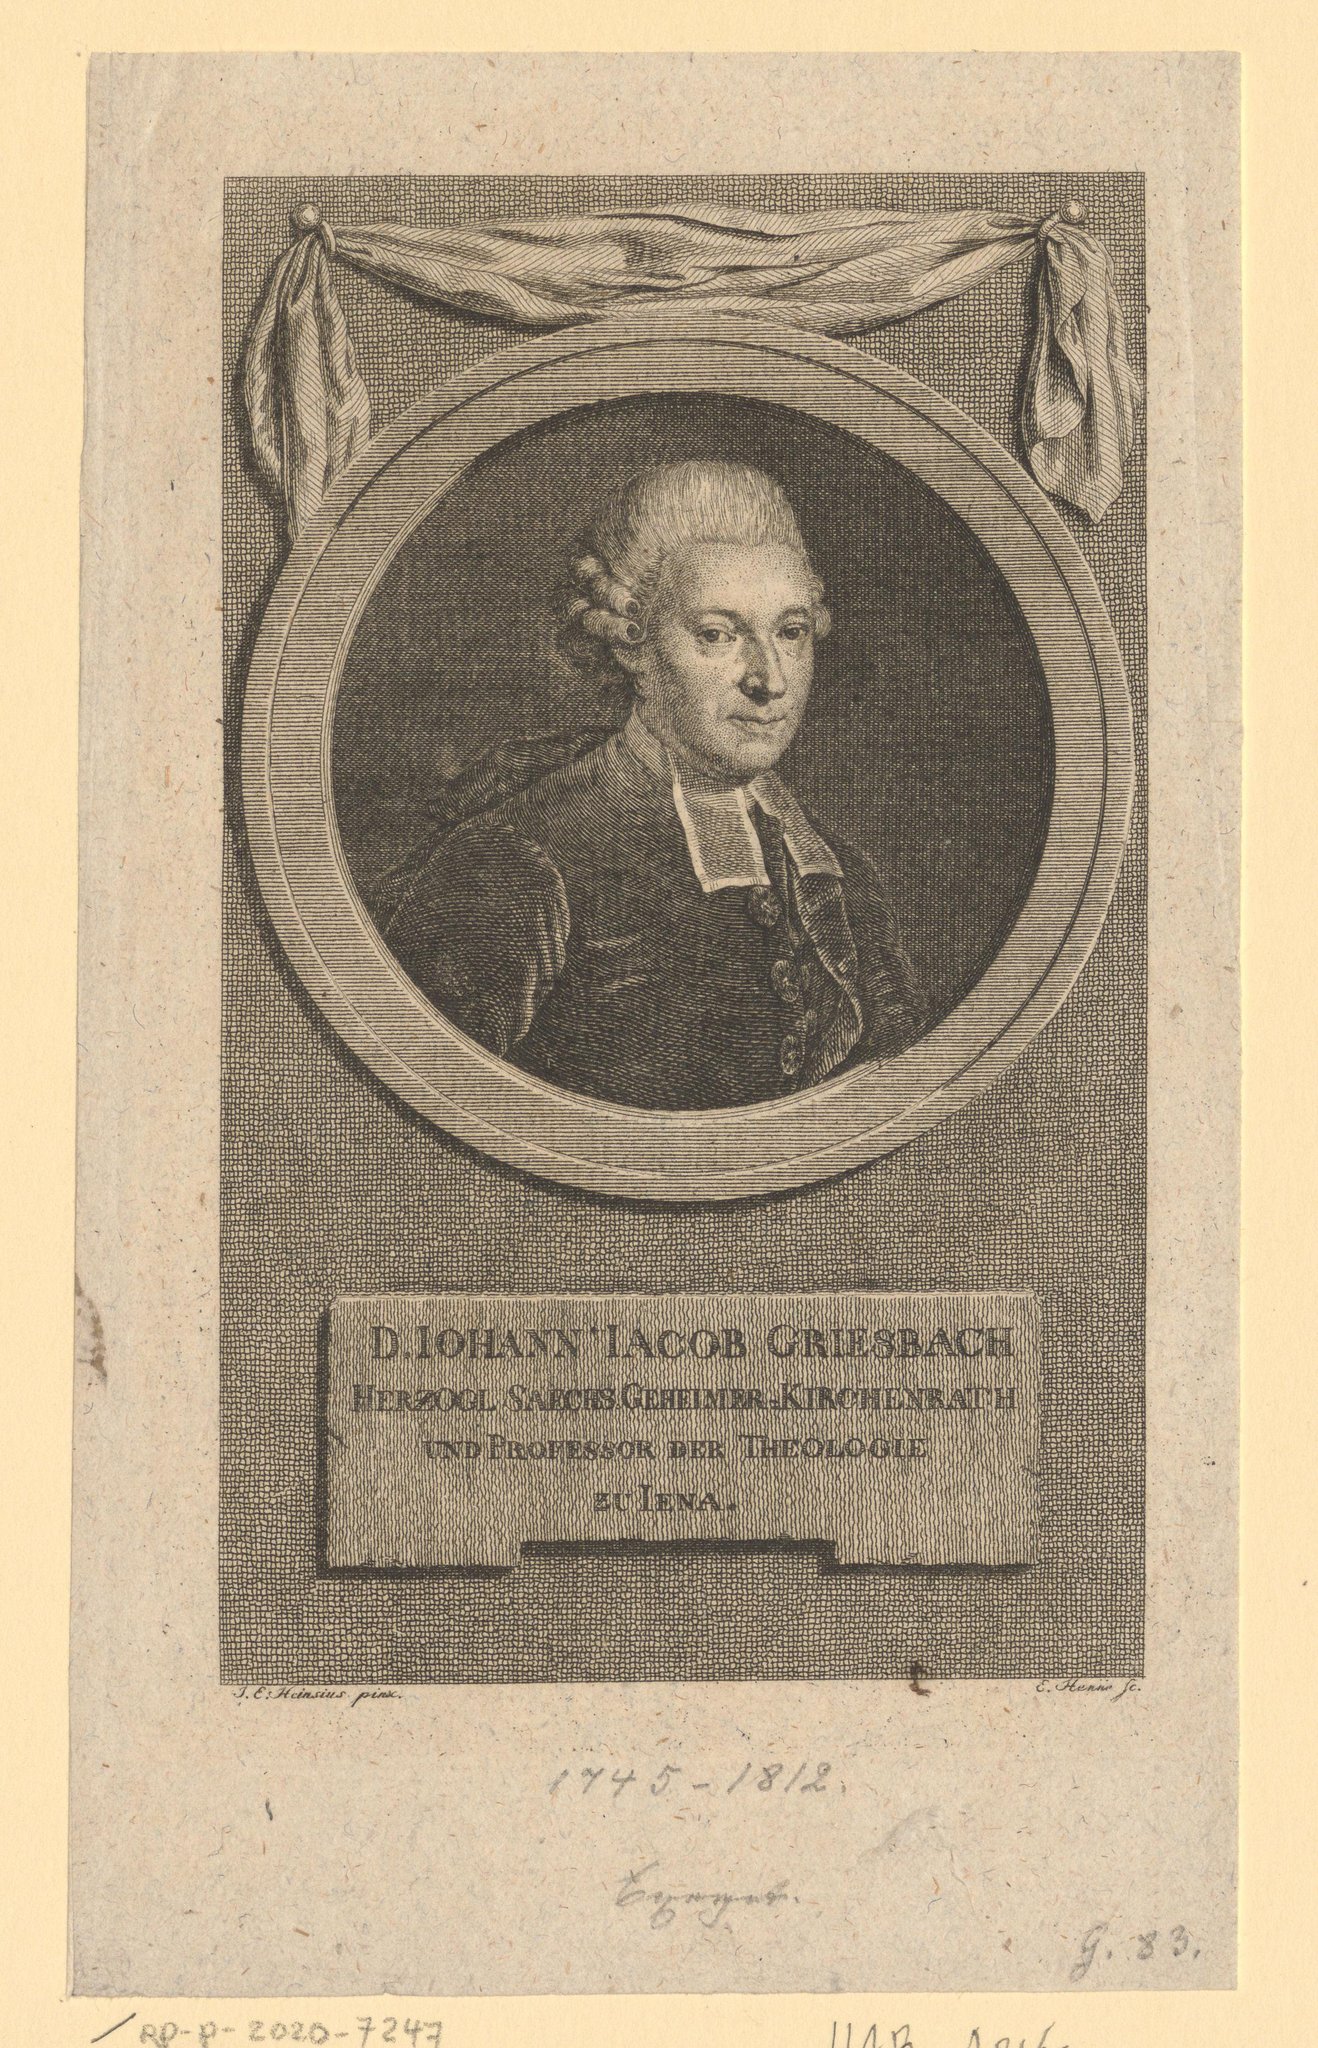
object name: print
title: Portret van Johann Jacob Griesbach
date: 1787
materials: paper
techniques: engraving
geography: berlin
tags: theologian, historical persons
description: Prent uit: Allgemeine deutsche Bibliothek. Berlijn en Stettin: Friedrich Nicolai, 1787, dl. 72.